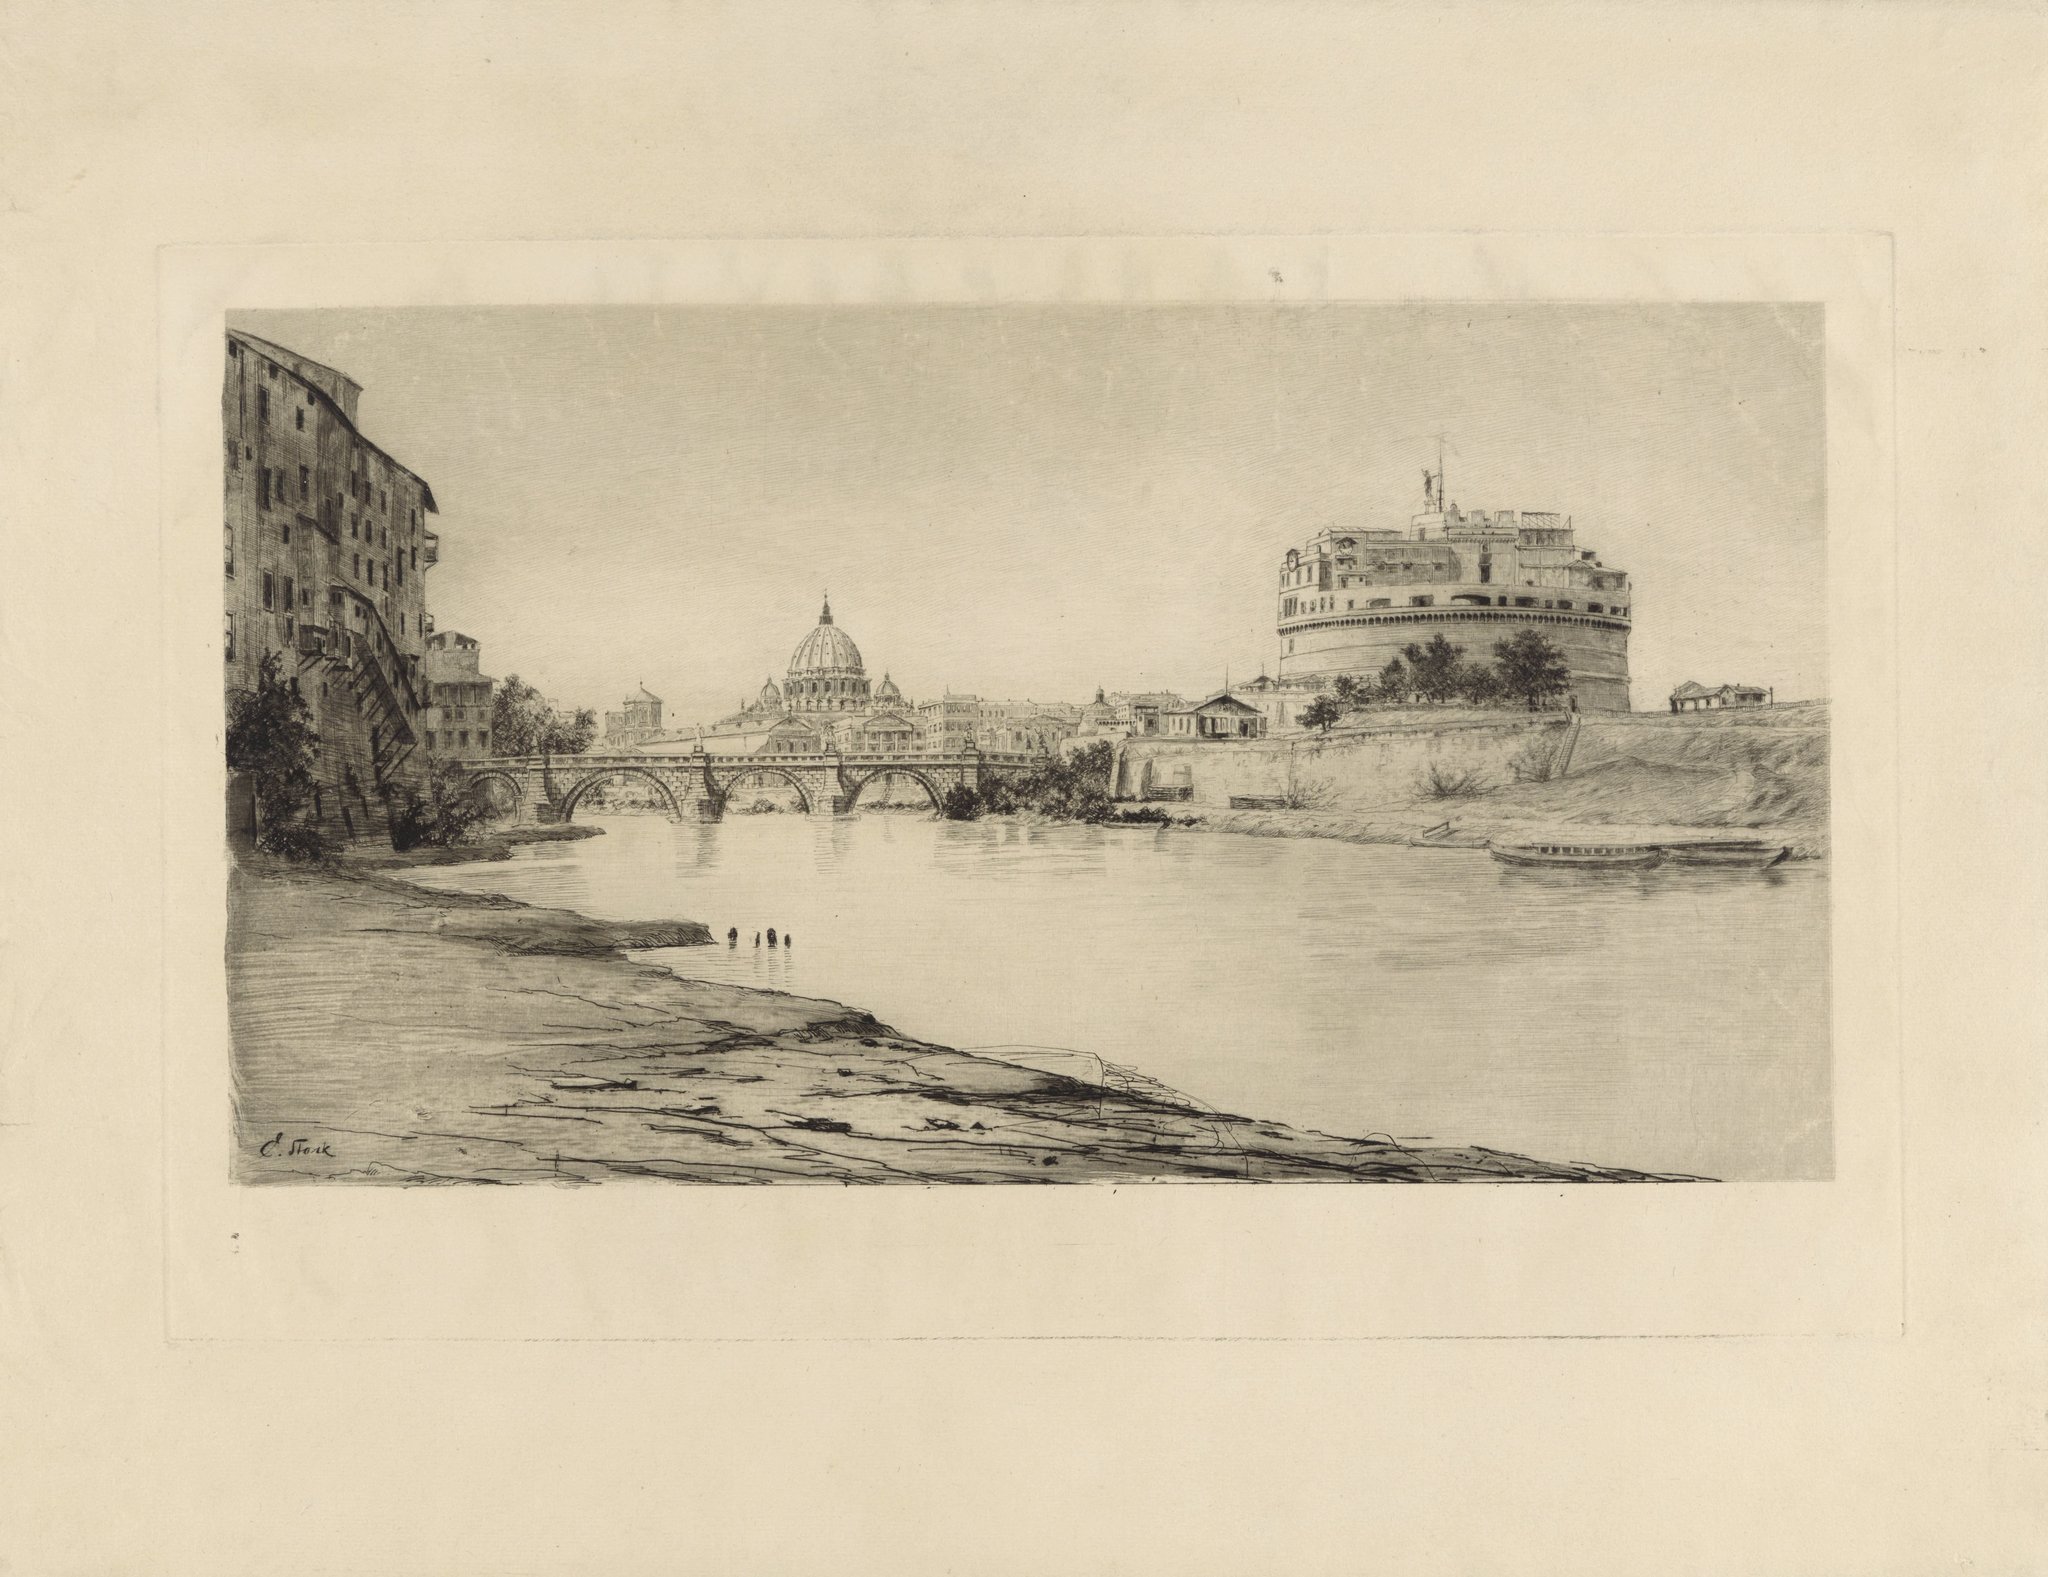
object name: print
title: Gezicht op de Engelenbrug te Rome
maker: elias stark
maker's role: draughtsman, print maker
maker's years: 1849-1933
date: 1859-1891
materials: paper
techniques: drypoint, etching, hand coloring, intaglio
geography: nieuwer-amstel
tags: city-view in general; 'veduta', river, bridge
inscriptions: collector's mark: Lugt 2228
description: Gezicht op Tiber en de Engelenbrug te Rome. Rechts de Engelenburcht, op de achtergrond de Sint Pieter.